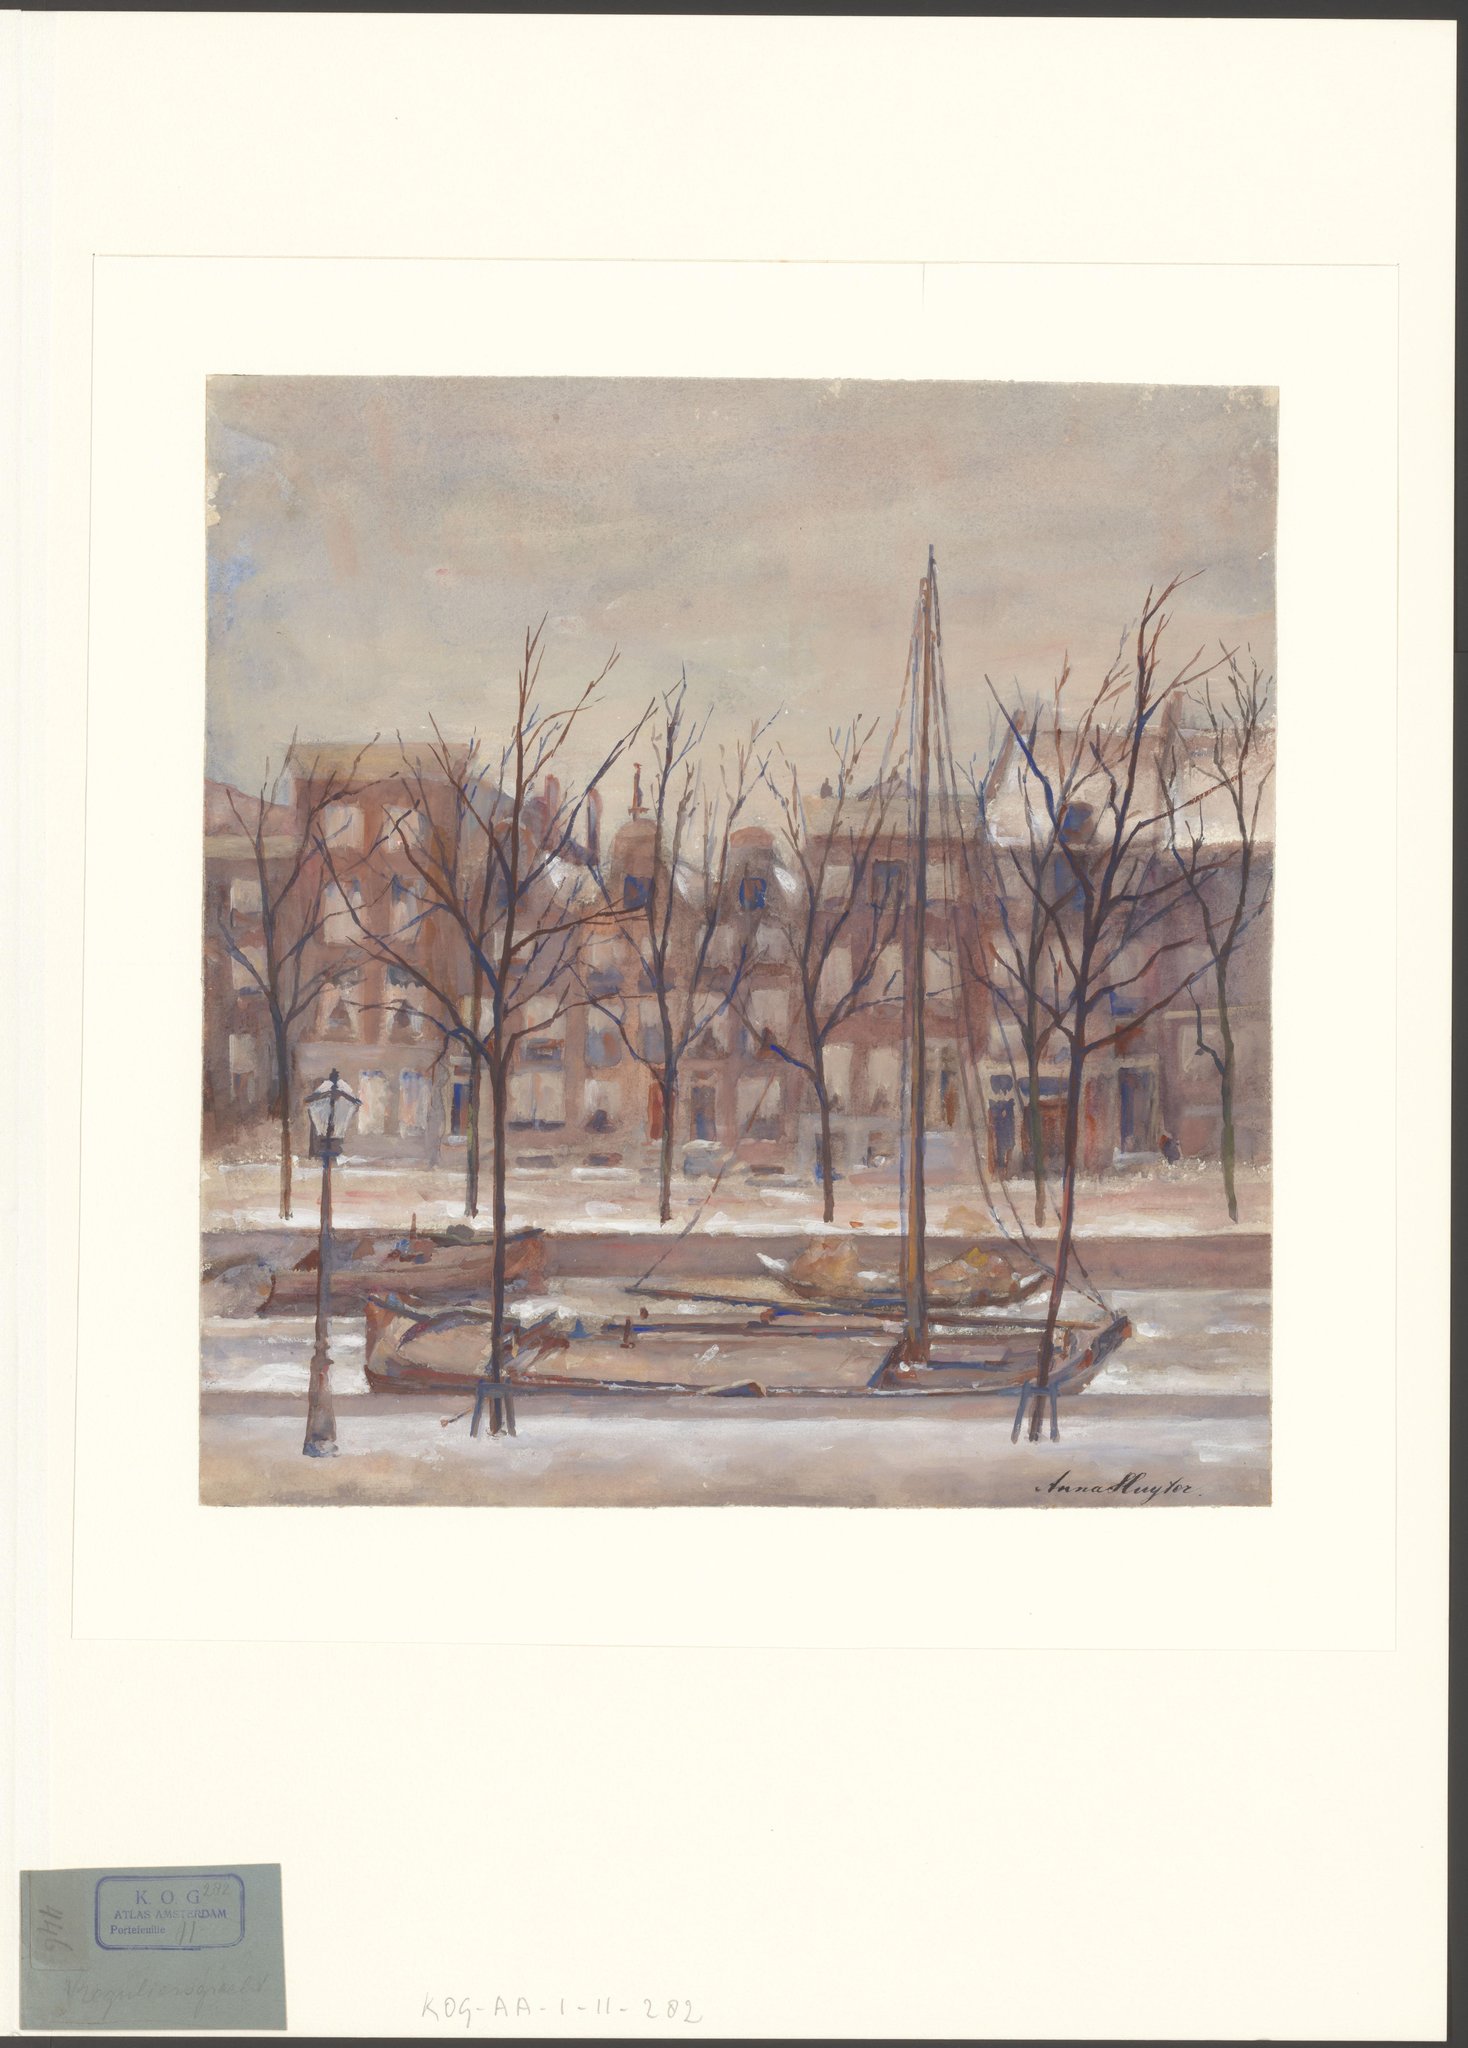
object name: drawing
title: Gezicht op de Reguliersgracht in de winter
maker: Anonymous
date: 1875-1975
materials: paint, gouache, paper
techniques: brush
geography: amsterdam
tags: city-view in general; 'veduta', canal, the usual house or row of houses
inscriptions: collector's mark: ‘11’ Lugt 1641b, inscription: ‘Reguliersgracht’, signature: ‘Anna Sluyter’, inscription: ‘Port. 11 - 282’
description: Onderwerpsrubriek binnen de Atlas Amsterdam: Raadhuisstraat, Raamgracht, Raamplein, Rapenburgerstraat, Reguliersgracht, Reguliersbreestraat.